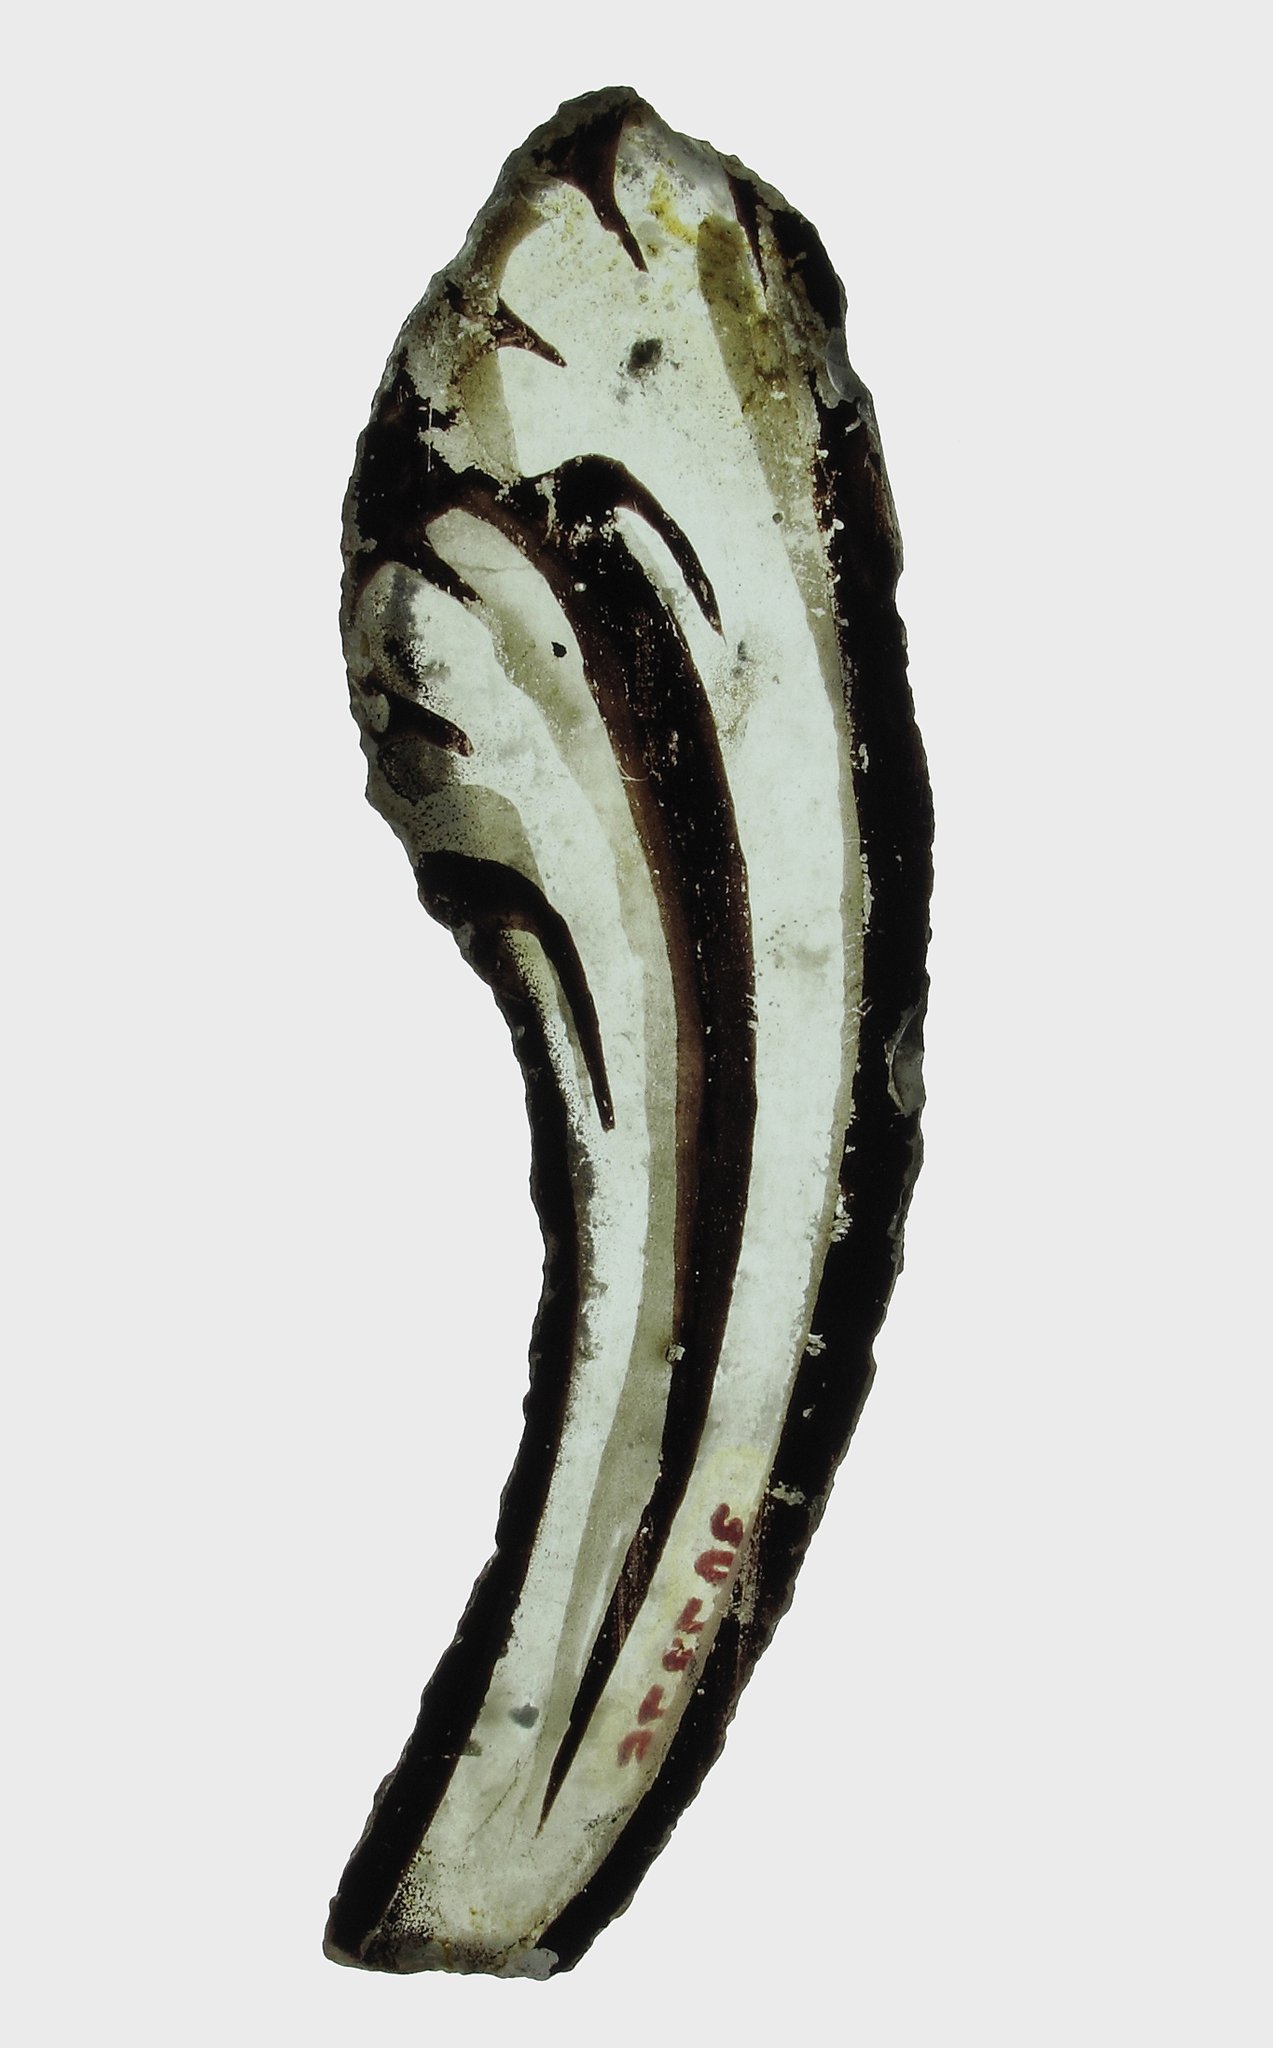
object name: fragment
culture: european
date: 1301-1500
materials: glass, metal, paint